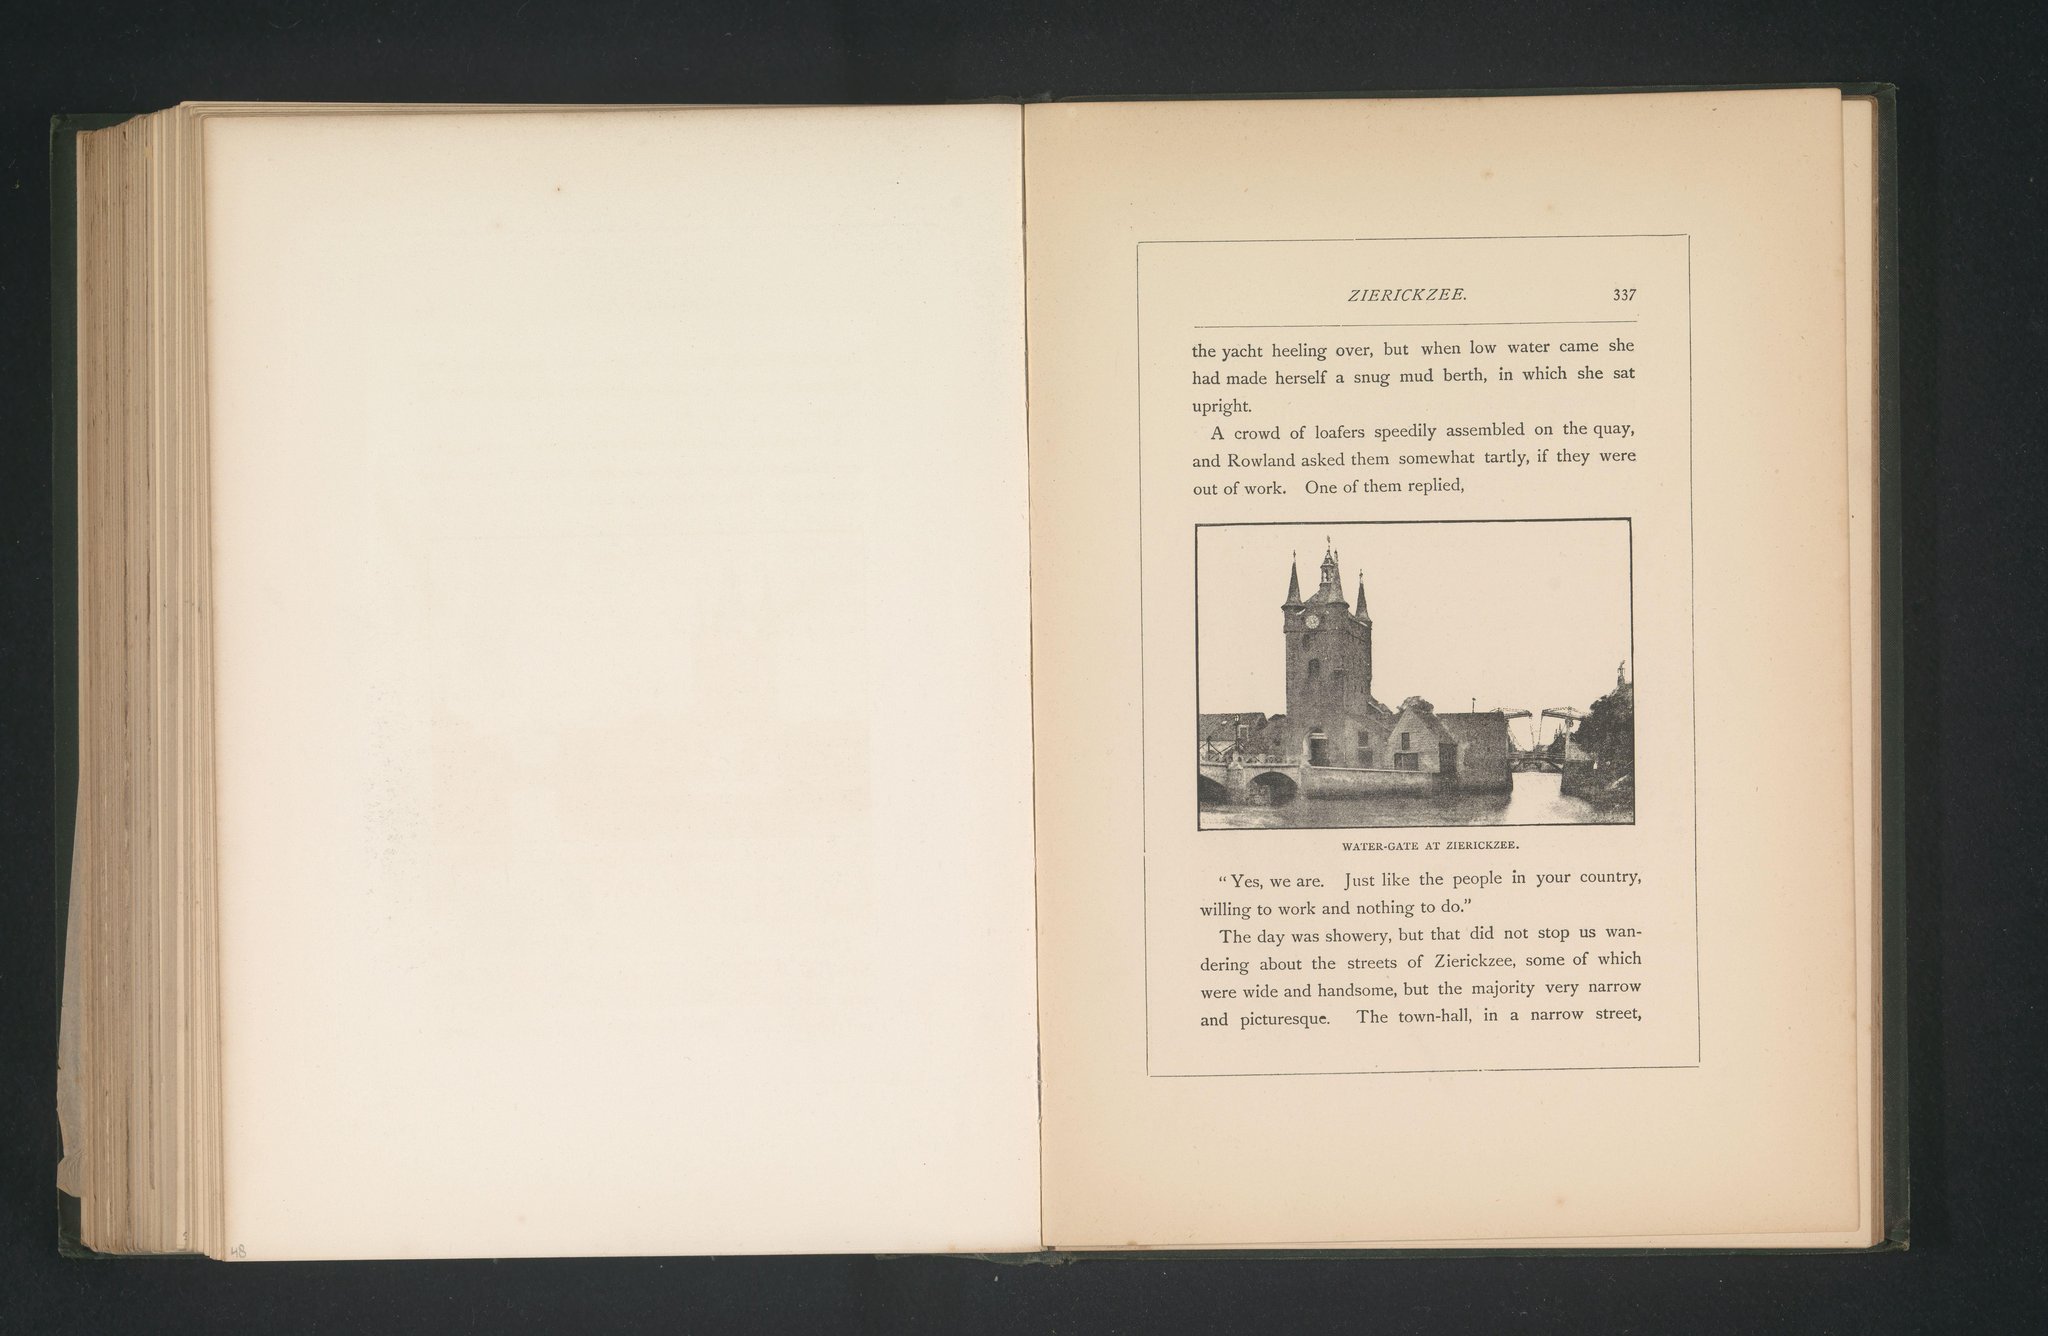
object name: photomechanical print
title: Gezicht op de Zuidhavenpoort in Zierikzee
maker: george christopher davies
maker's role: fotograaf, geoloog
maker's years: 1849-1922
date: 1881-1886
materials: paper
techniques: autotype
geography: london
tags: canals, waters (in city), city-gate